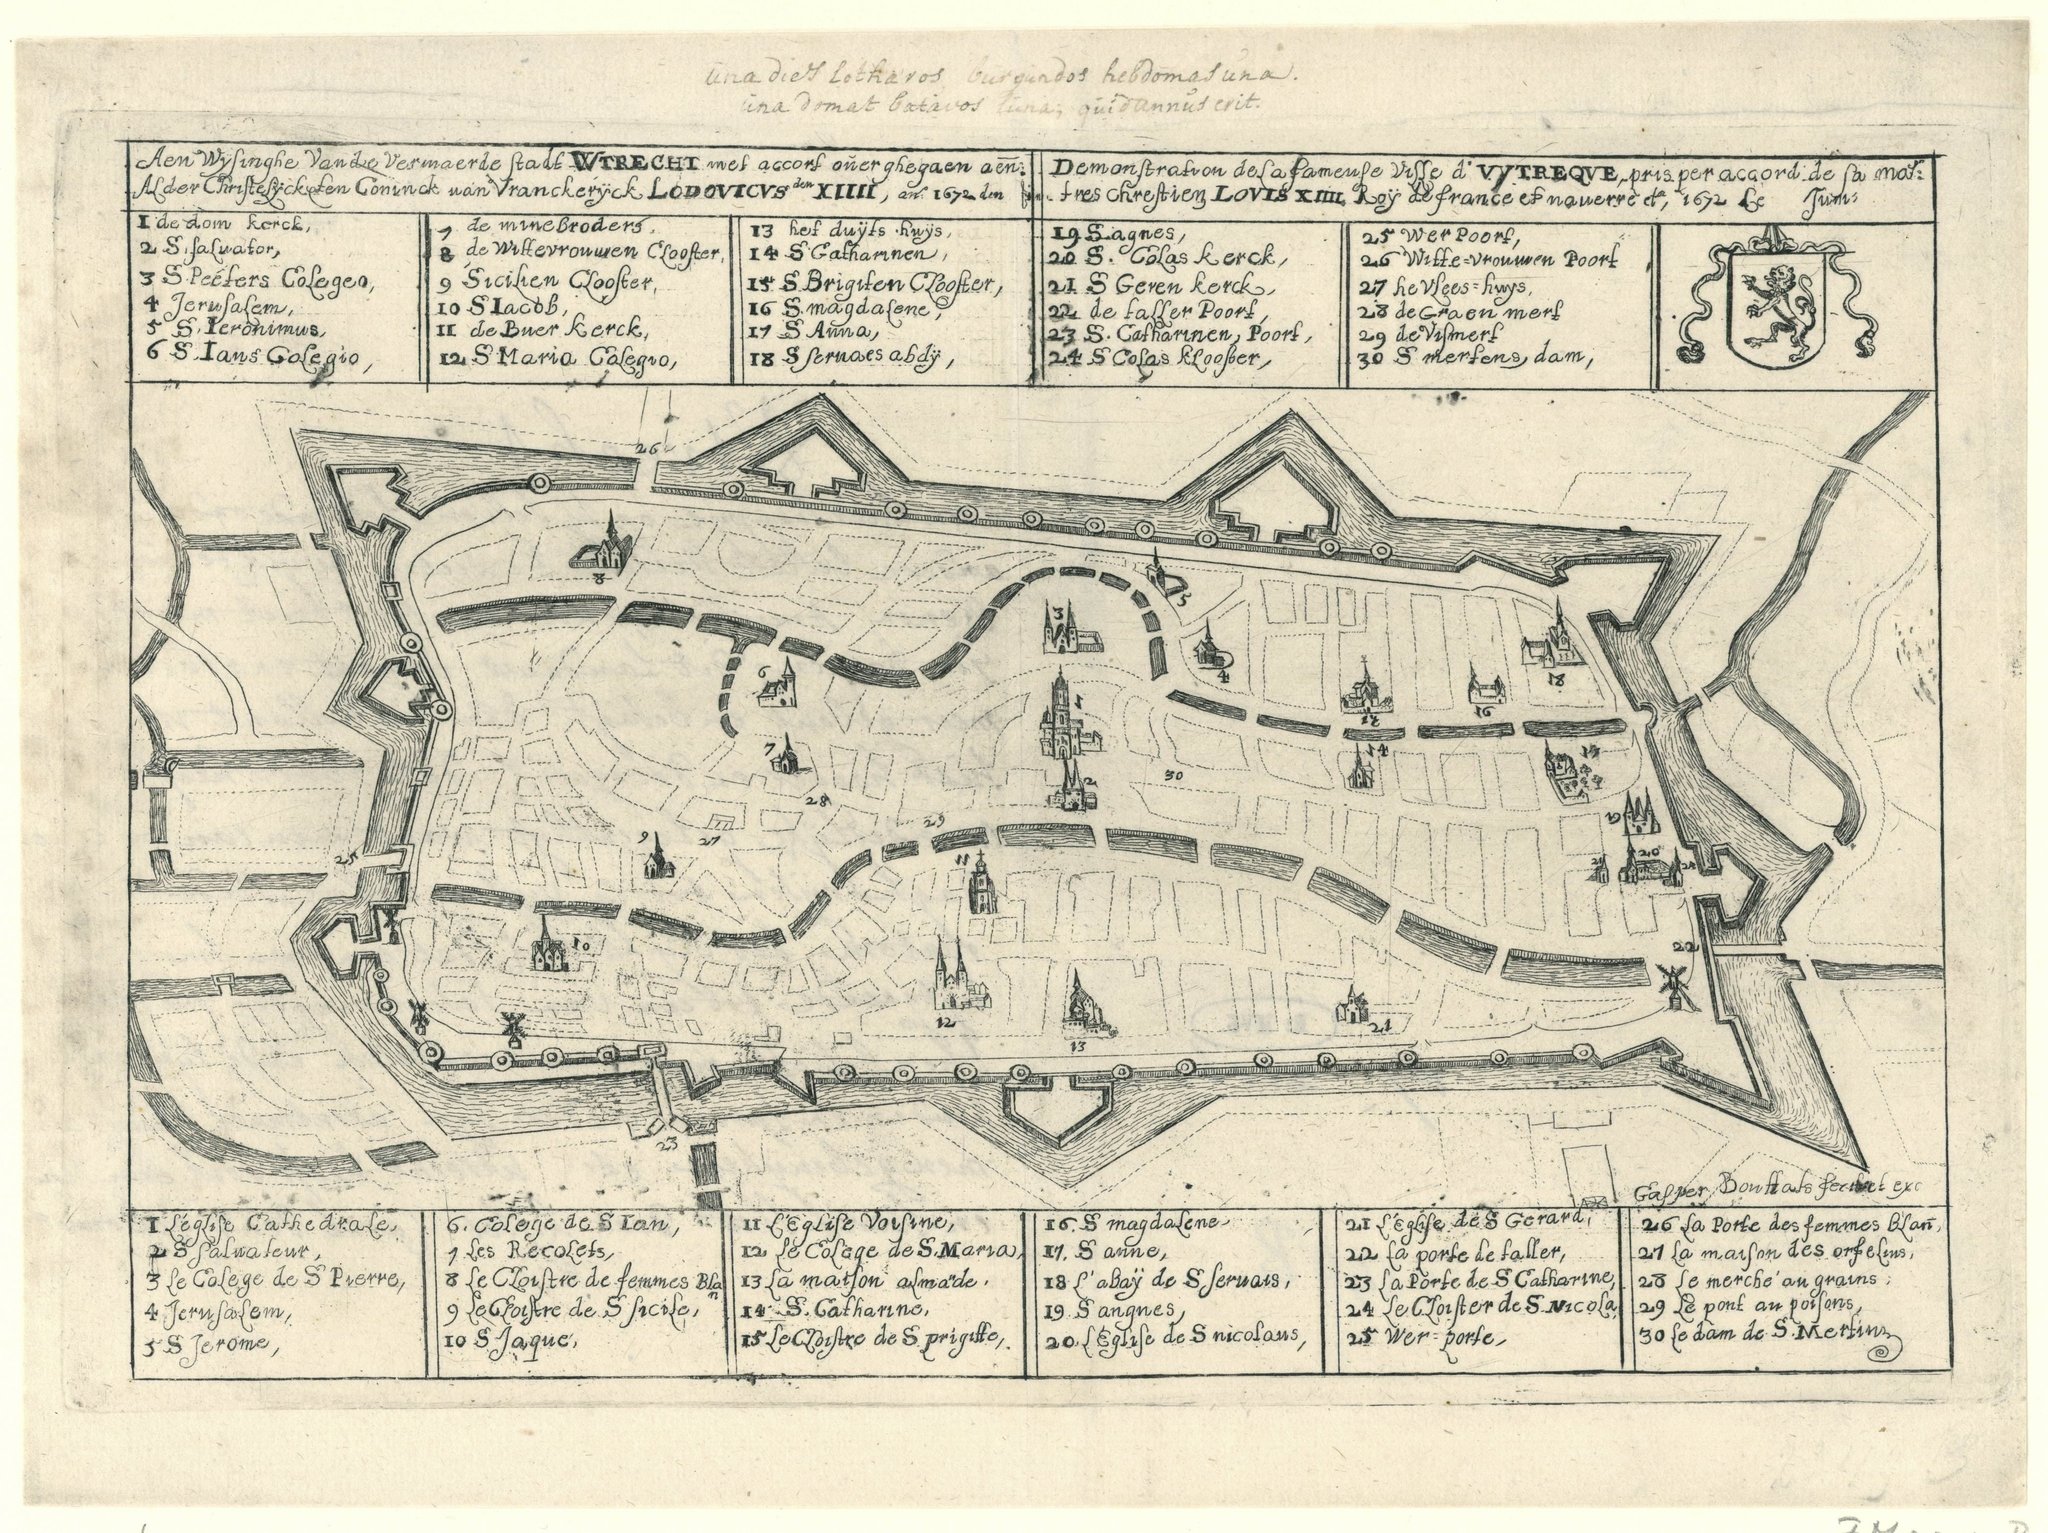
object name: print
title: Afbeeldinghe van eenighe Steden ende Fortificatien Van de welcke differente soo ghewonnen als overgegeven zijn aen sijn Majesteyt van Vranckerijk Lodovicus XIV ende aen sijn Doorluchtighijt den Bisschop van Munster Christophori Bernardus van Galen. Anno 1672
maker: gaspar bouttats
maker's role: print maker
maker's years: 1640-1695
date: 1672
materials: paper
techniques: etching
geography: antwerp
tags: maps of cities, utrecht, rampjaar (disaster year)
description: Plan van de stad Utrecht. Deze prent maakt deel uit van een groep van twaalf prenten, merendeels geëetst en uitgegeven door Gaspar Bouttats, met gezichten op vestingen en steden veroverd door de Fransen en Munstersen in 1672. Plattegronden met legenda's in Frans en Nederlands.